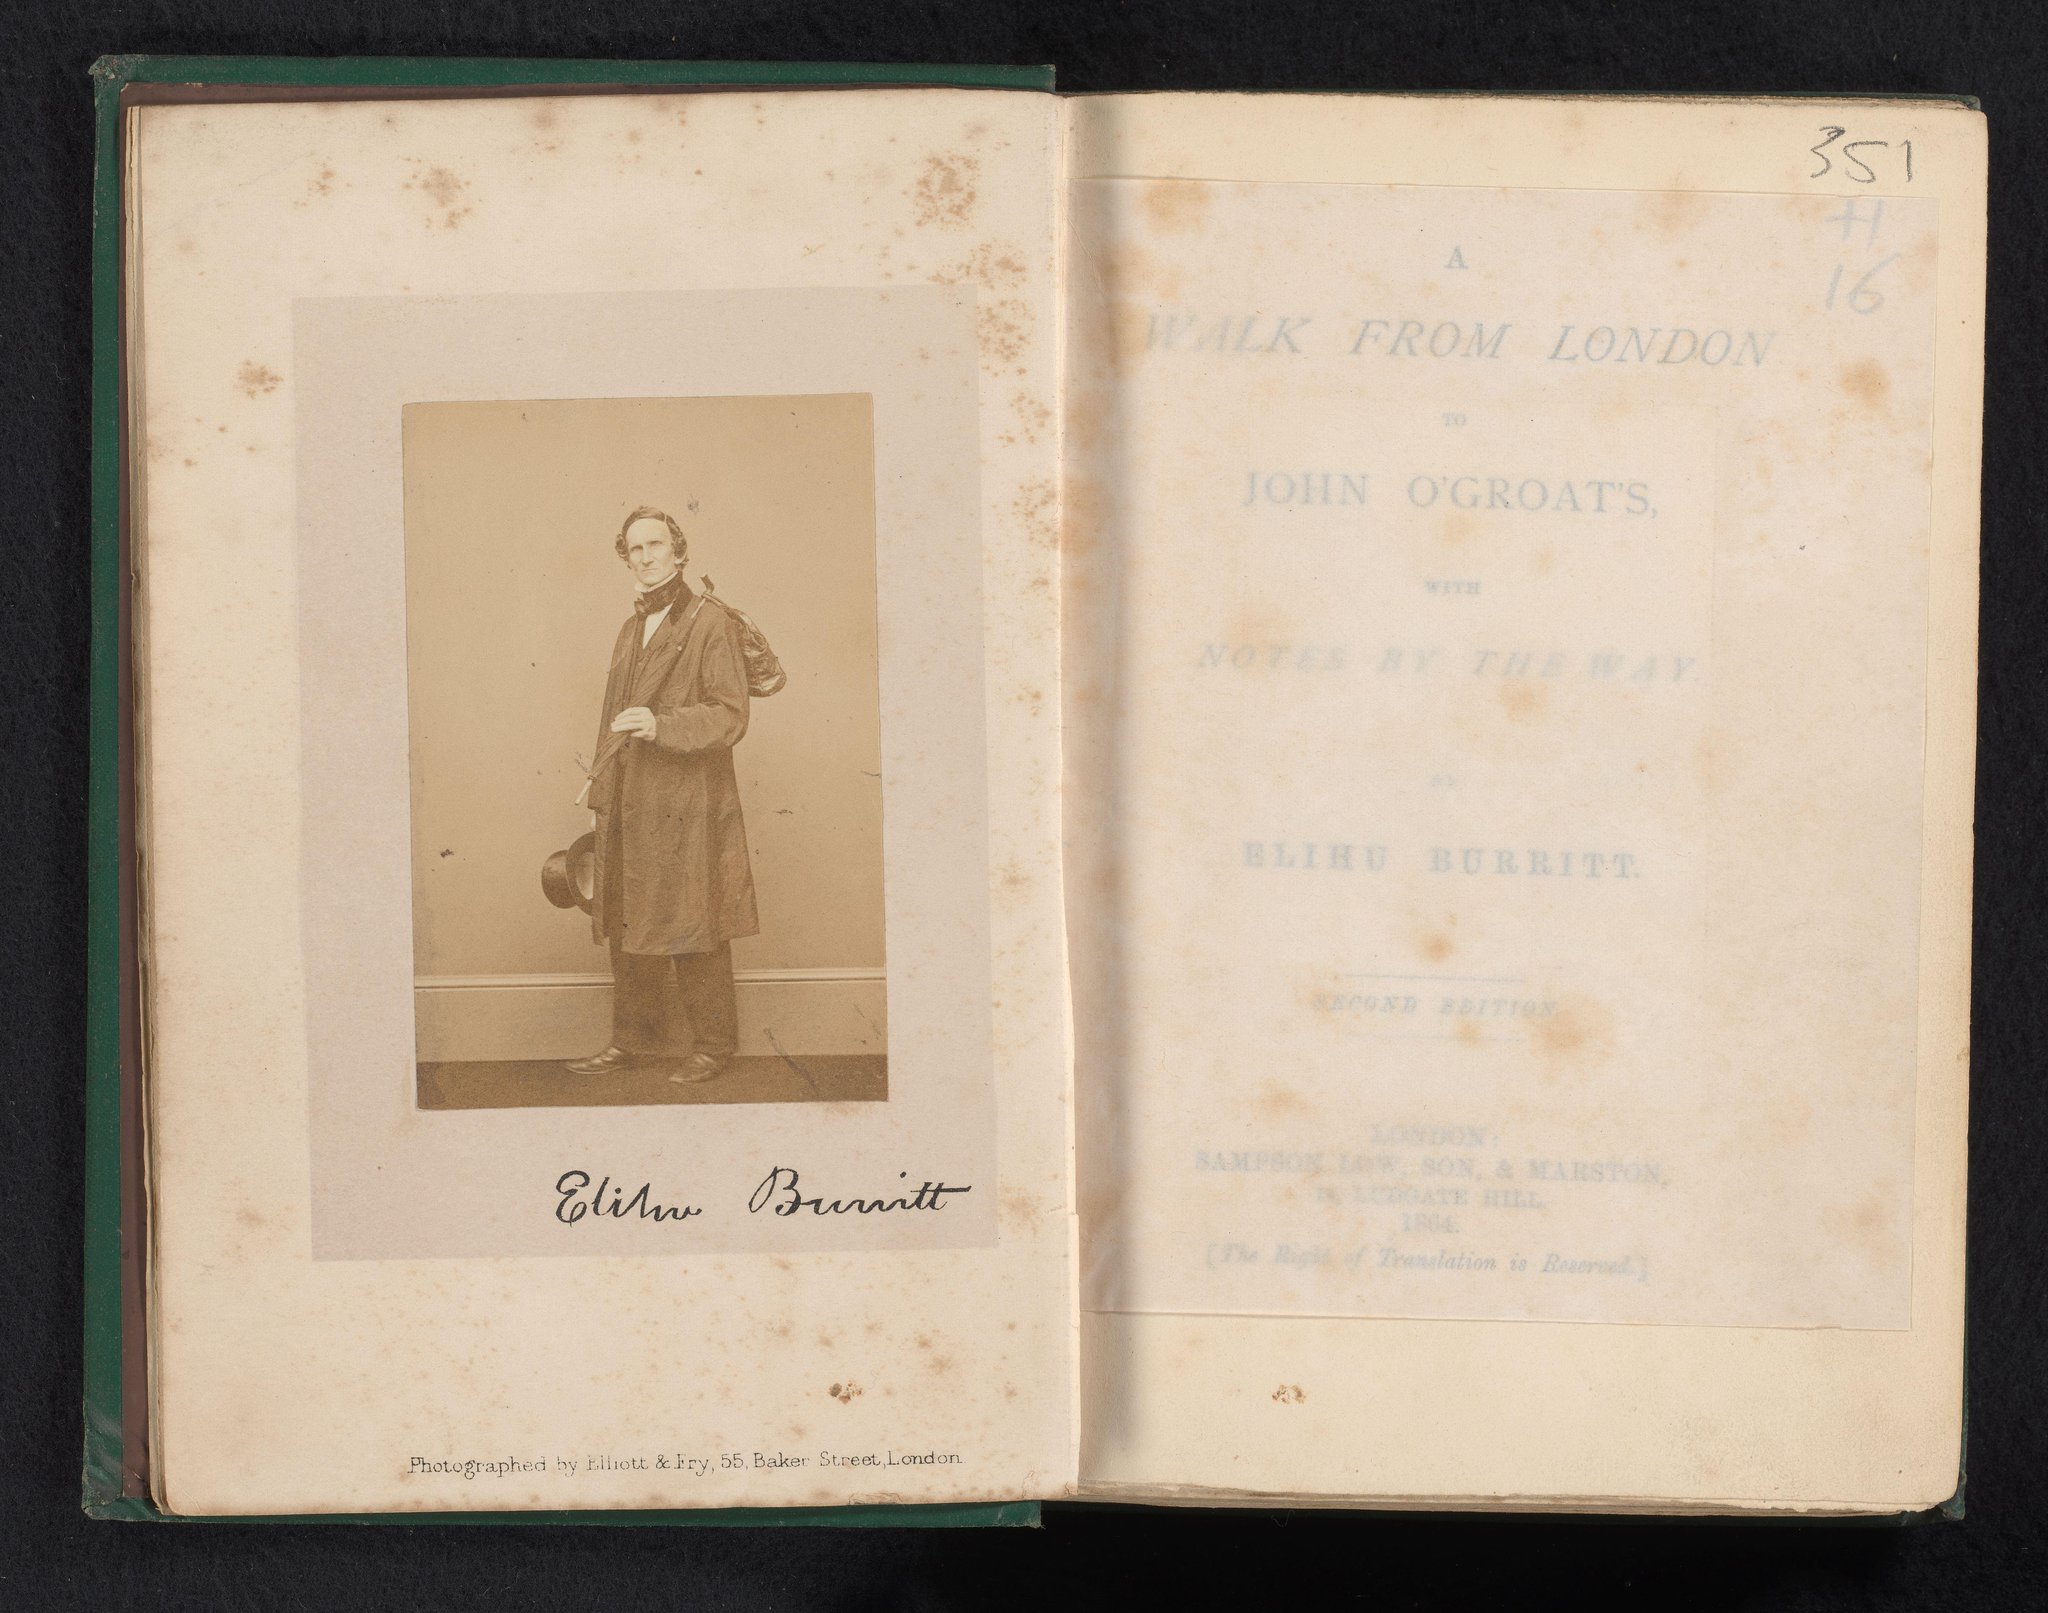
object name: page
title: Portret van Elihu Burritt met een knapzak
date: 1859-1864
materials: paper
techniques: albumen print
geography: london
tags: elihu burritt, historical persons, diplomacy, diplomat, knapsack, rucksack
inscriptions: inscription: ‘Elihu Burnitt’, address: ‘Photographed by Elliott & Fry, 55, Baker Street, London.’